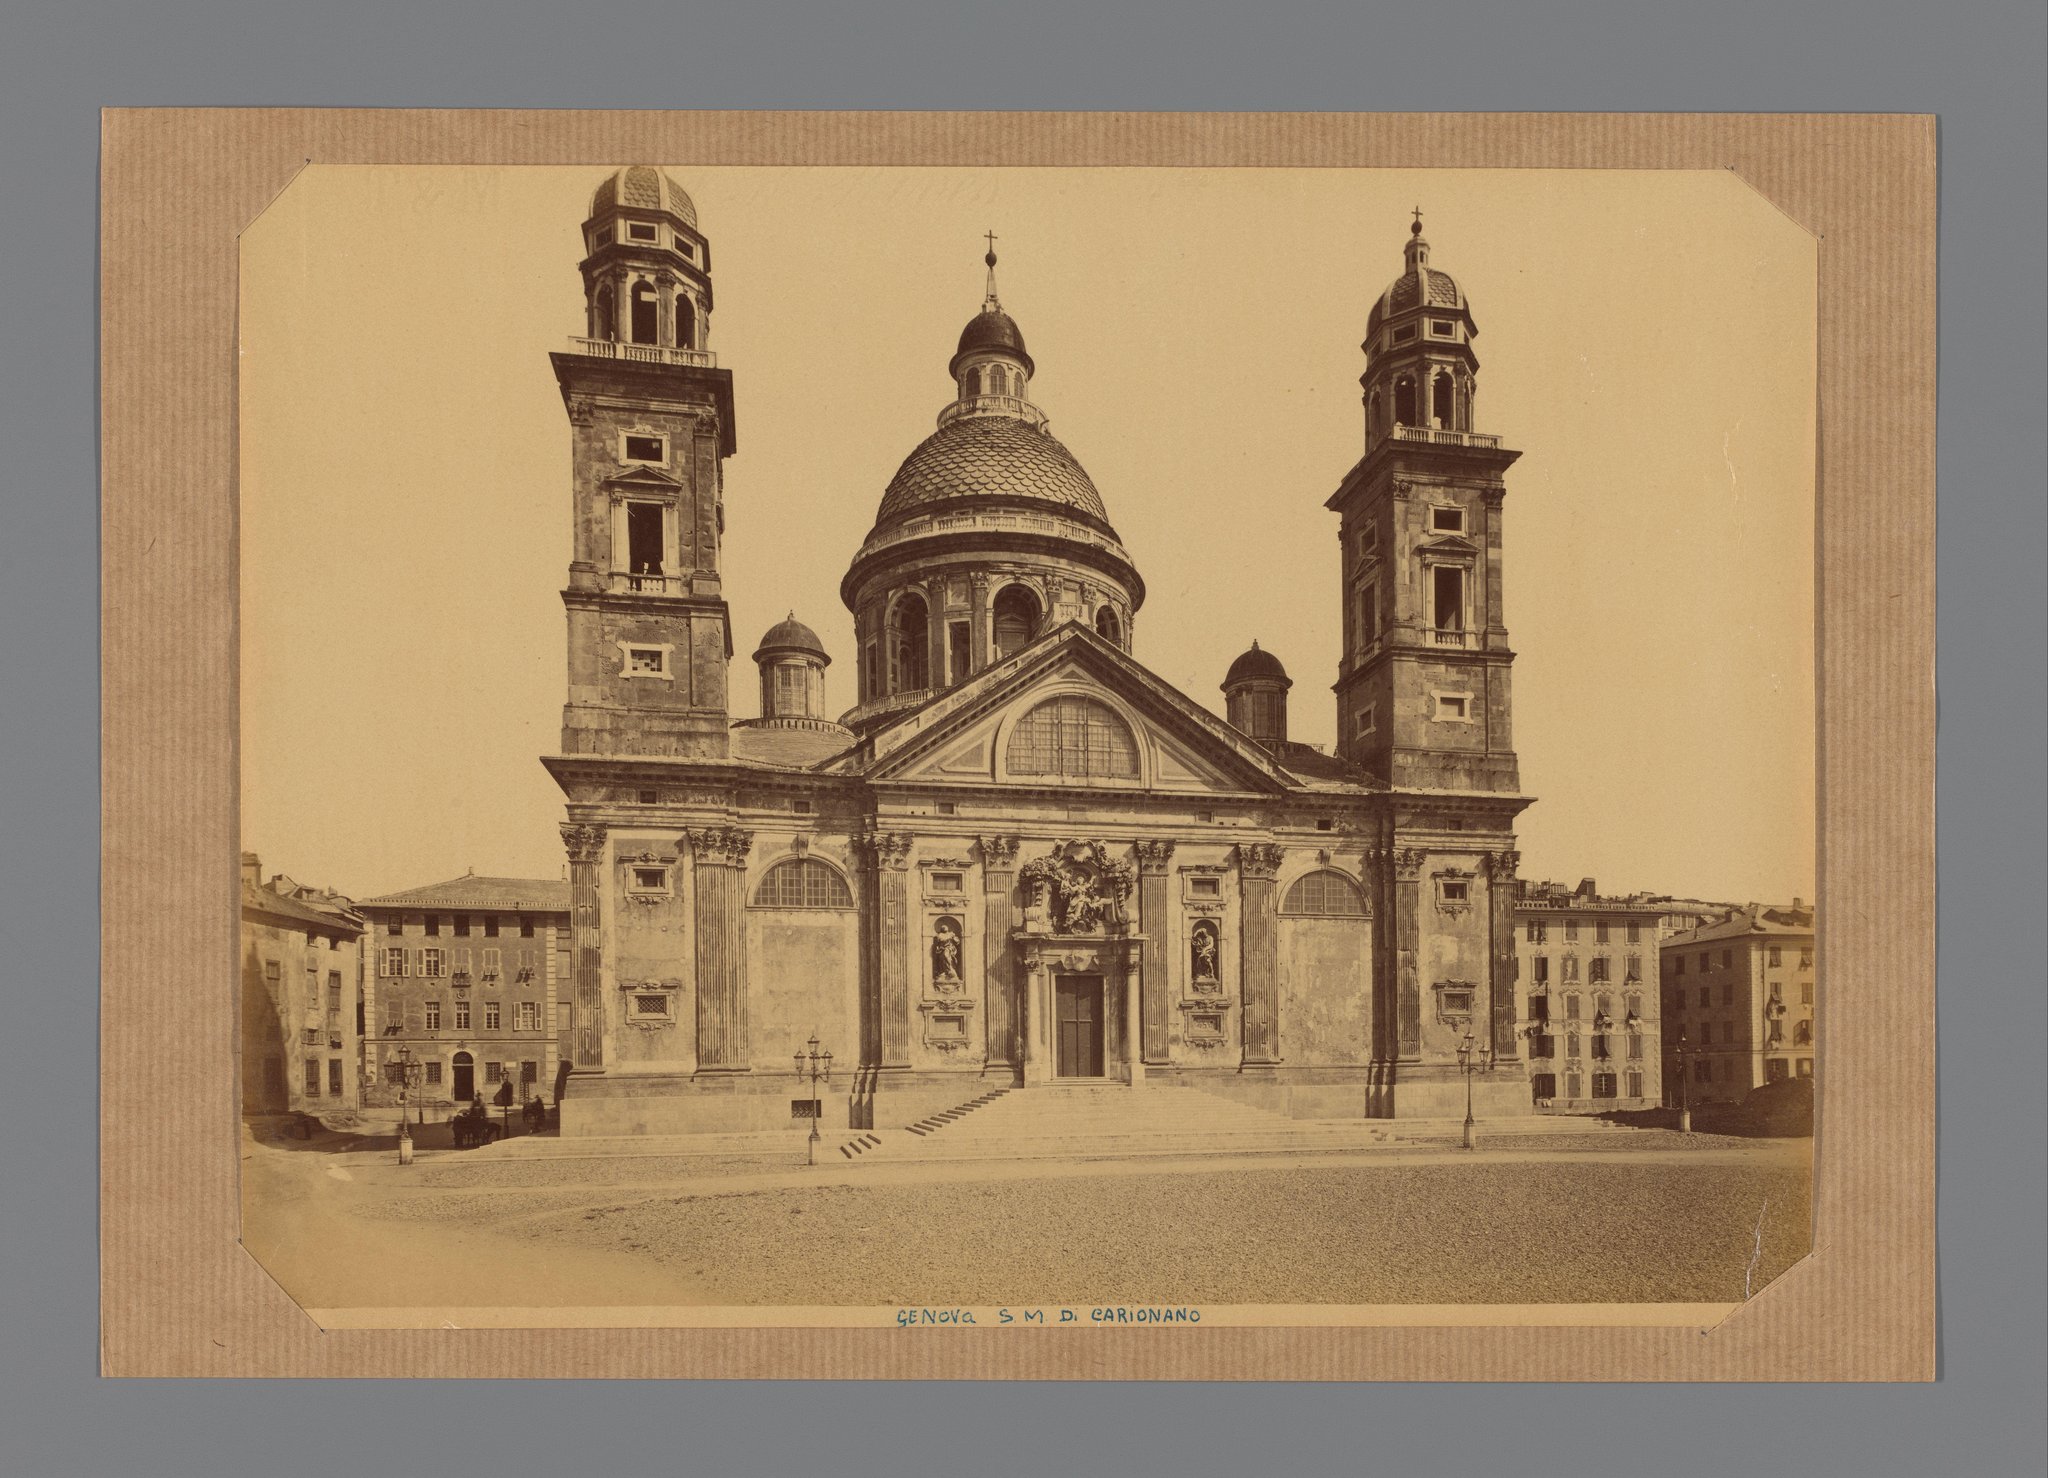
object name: photograph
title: Italië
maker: Anonymous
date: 1880-1910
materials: photographic support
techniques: albumen print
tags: italy